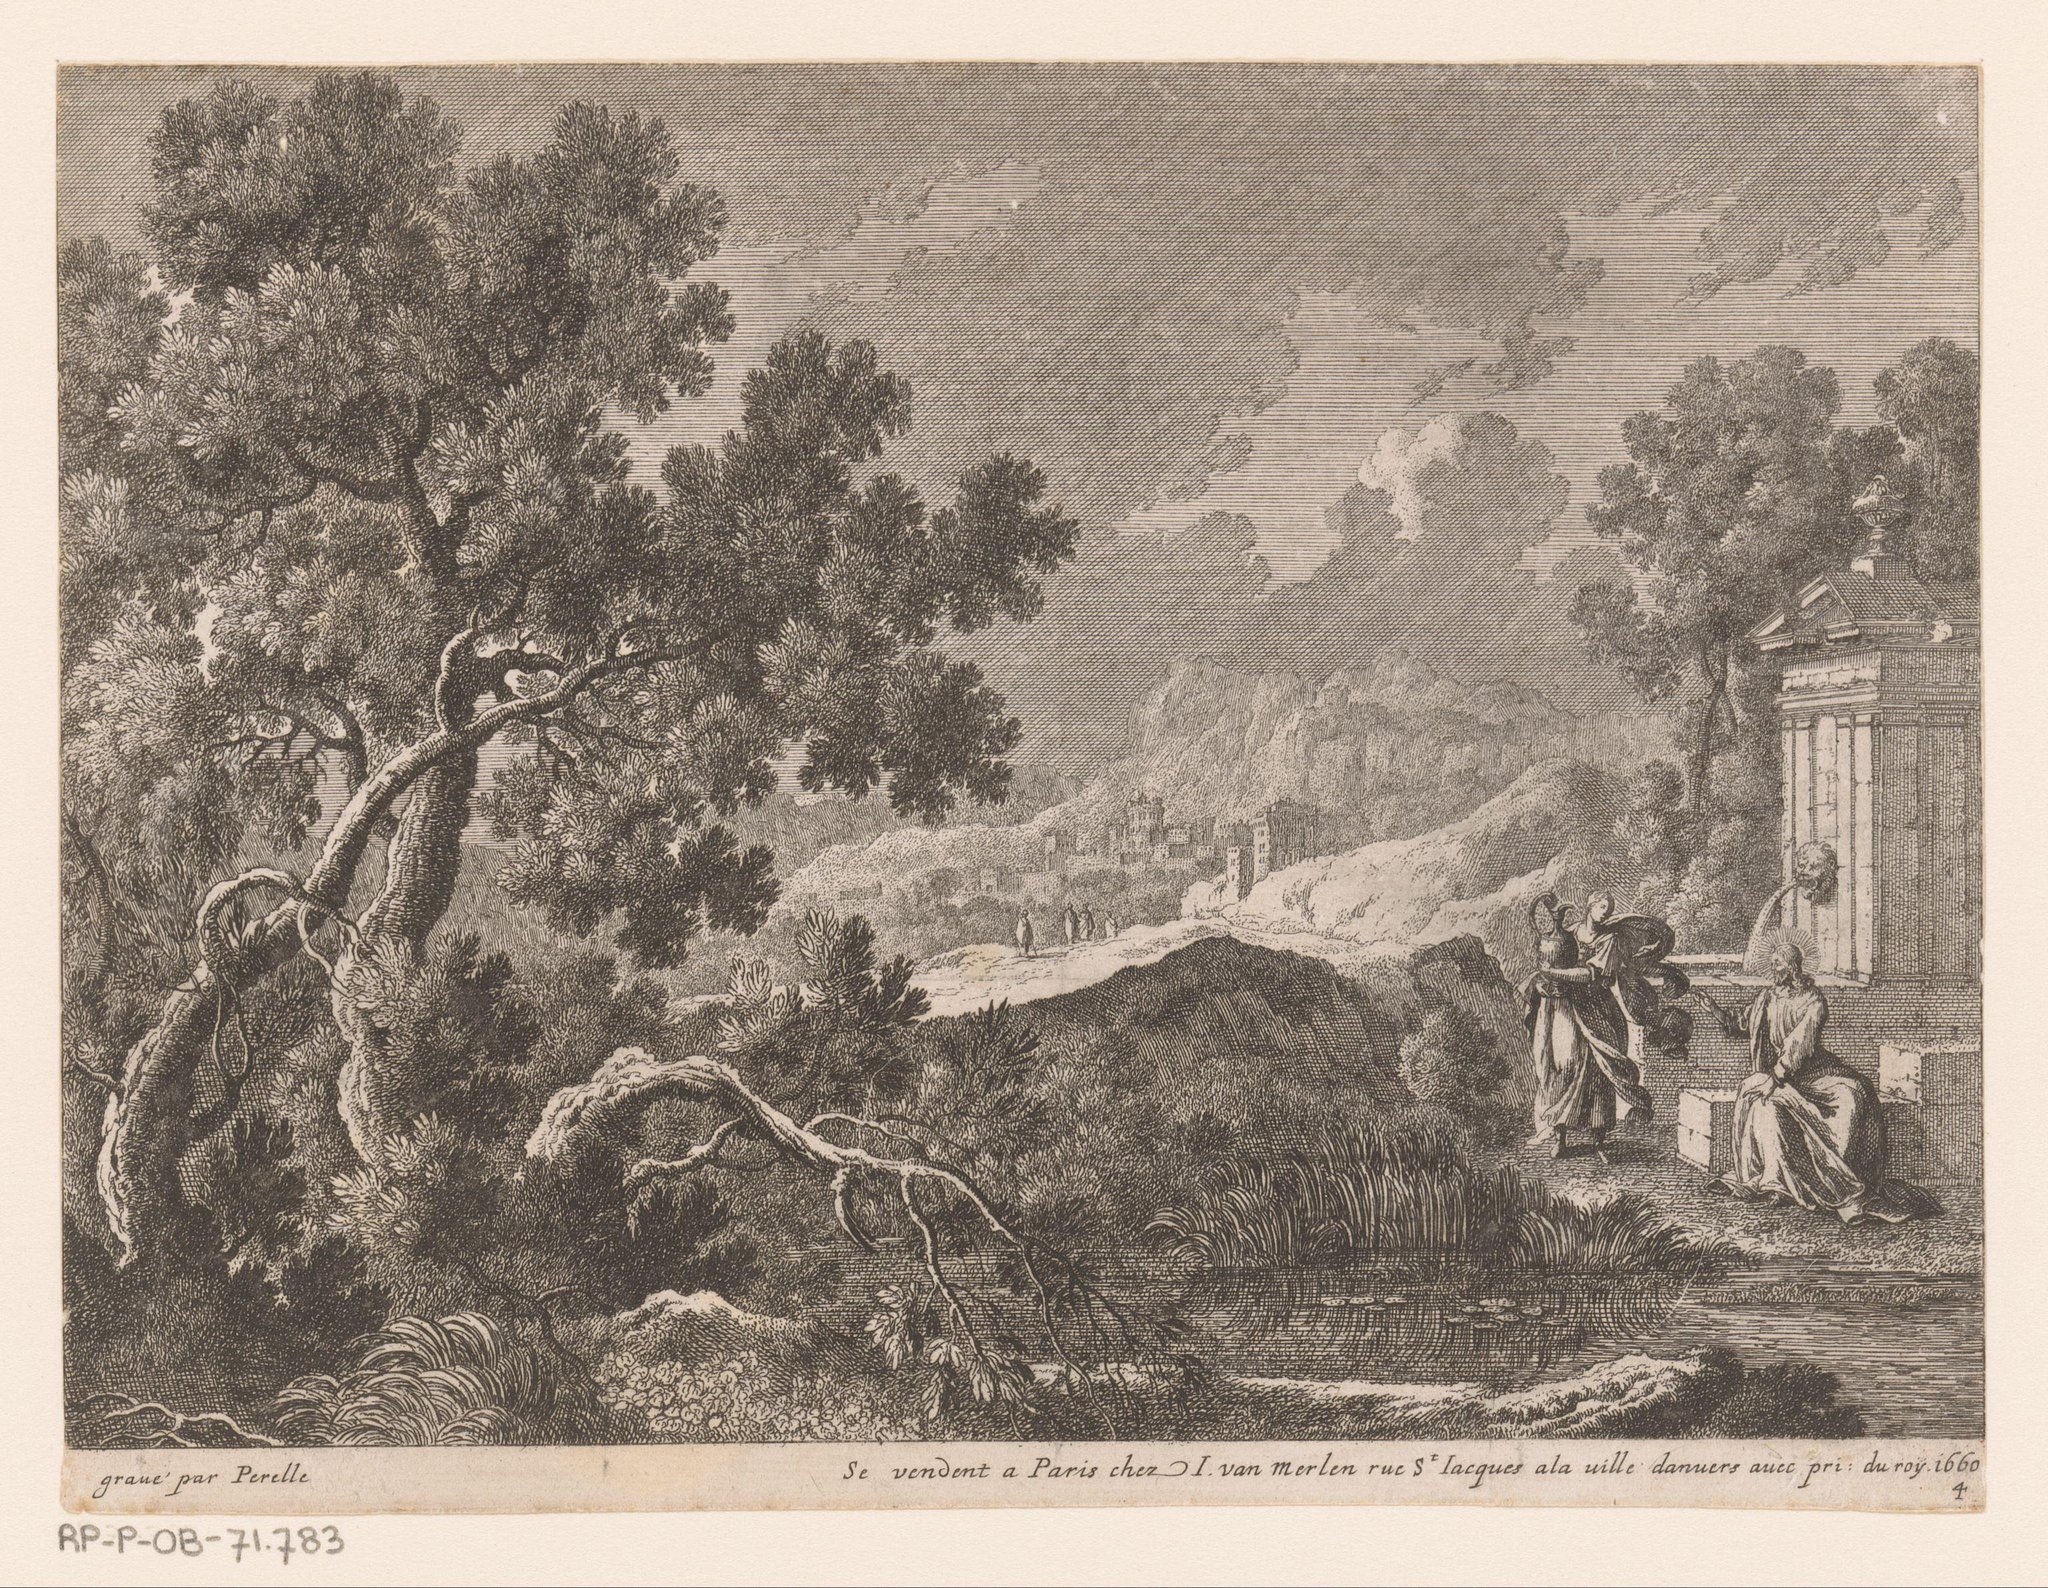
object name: print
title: Christus en de Samaritaanse vrouw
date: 1660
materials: paper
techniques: etching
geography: paris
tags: christ and the woman of samaria: sitting at jacob's well he asks her for a drink from her jug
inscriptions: collector's mark: Lugt 240